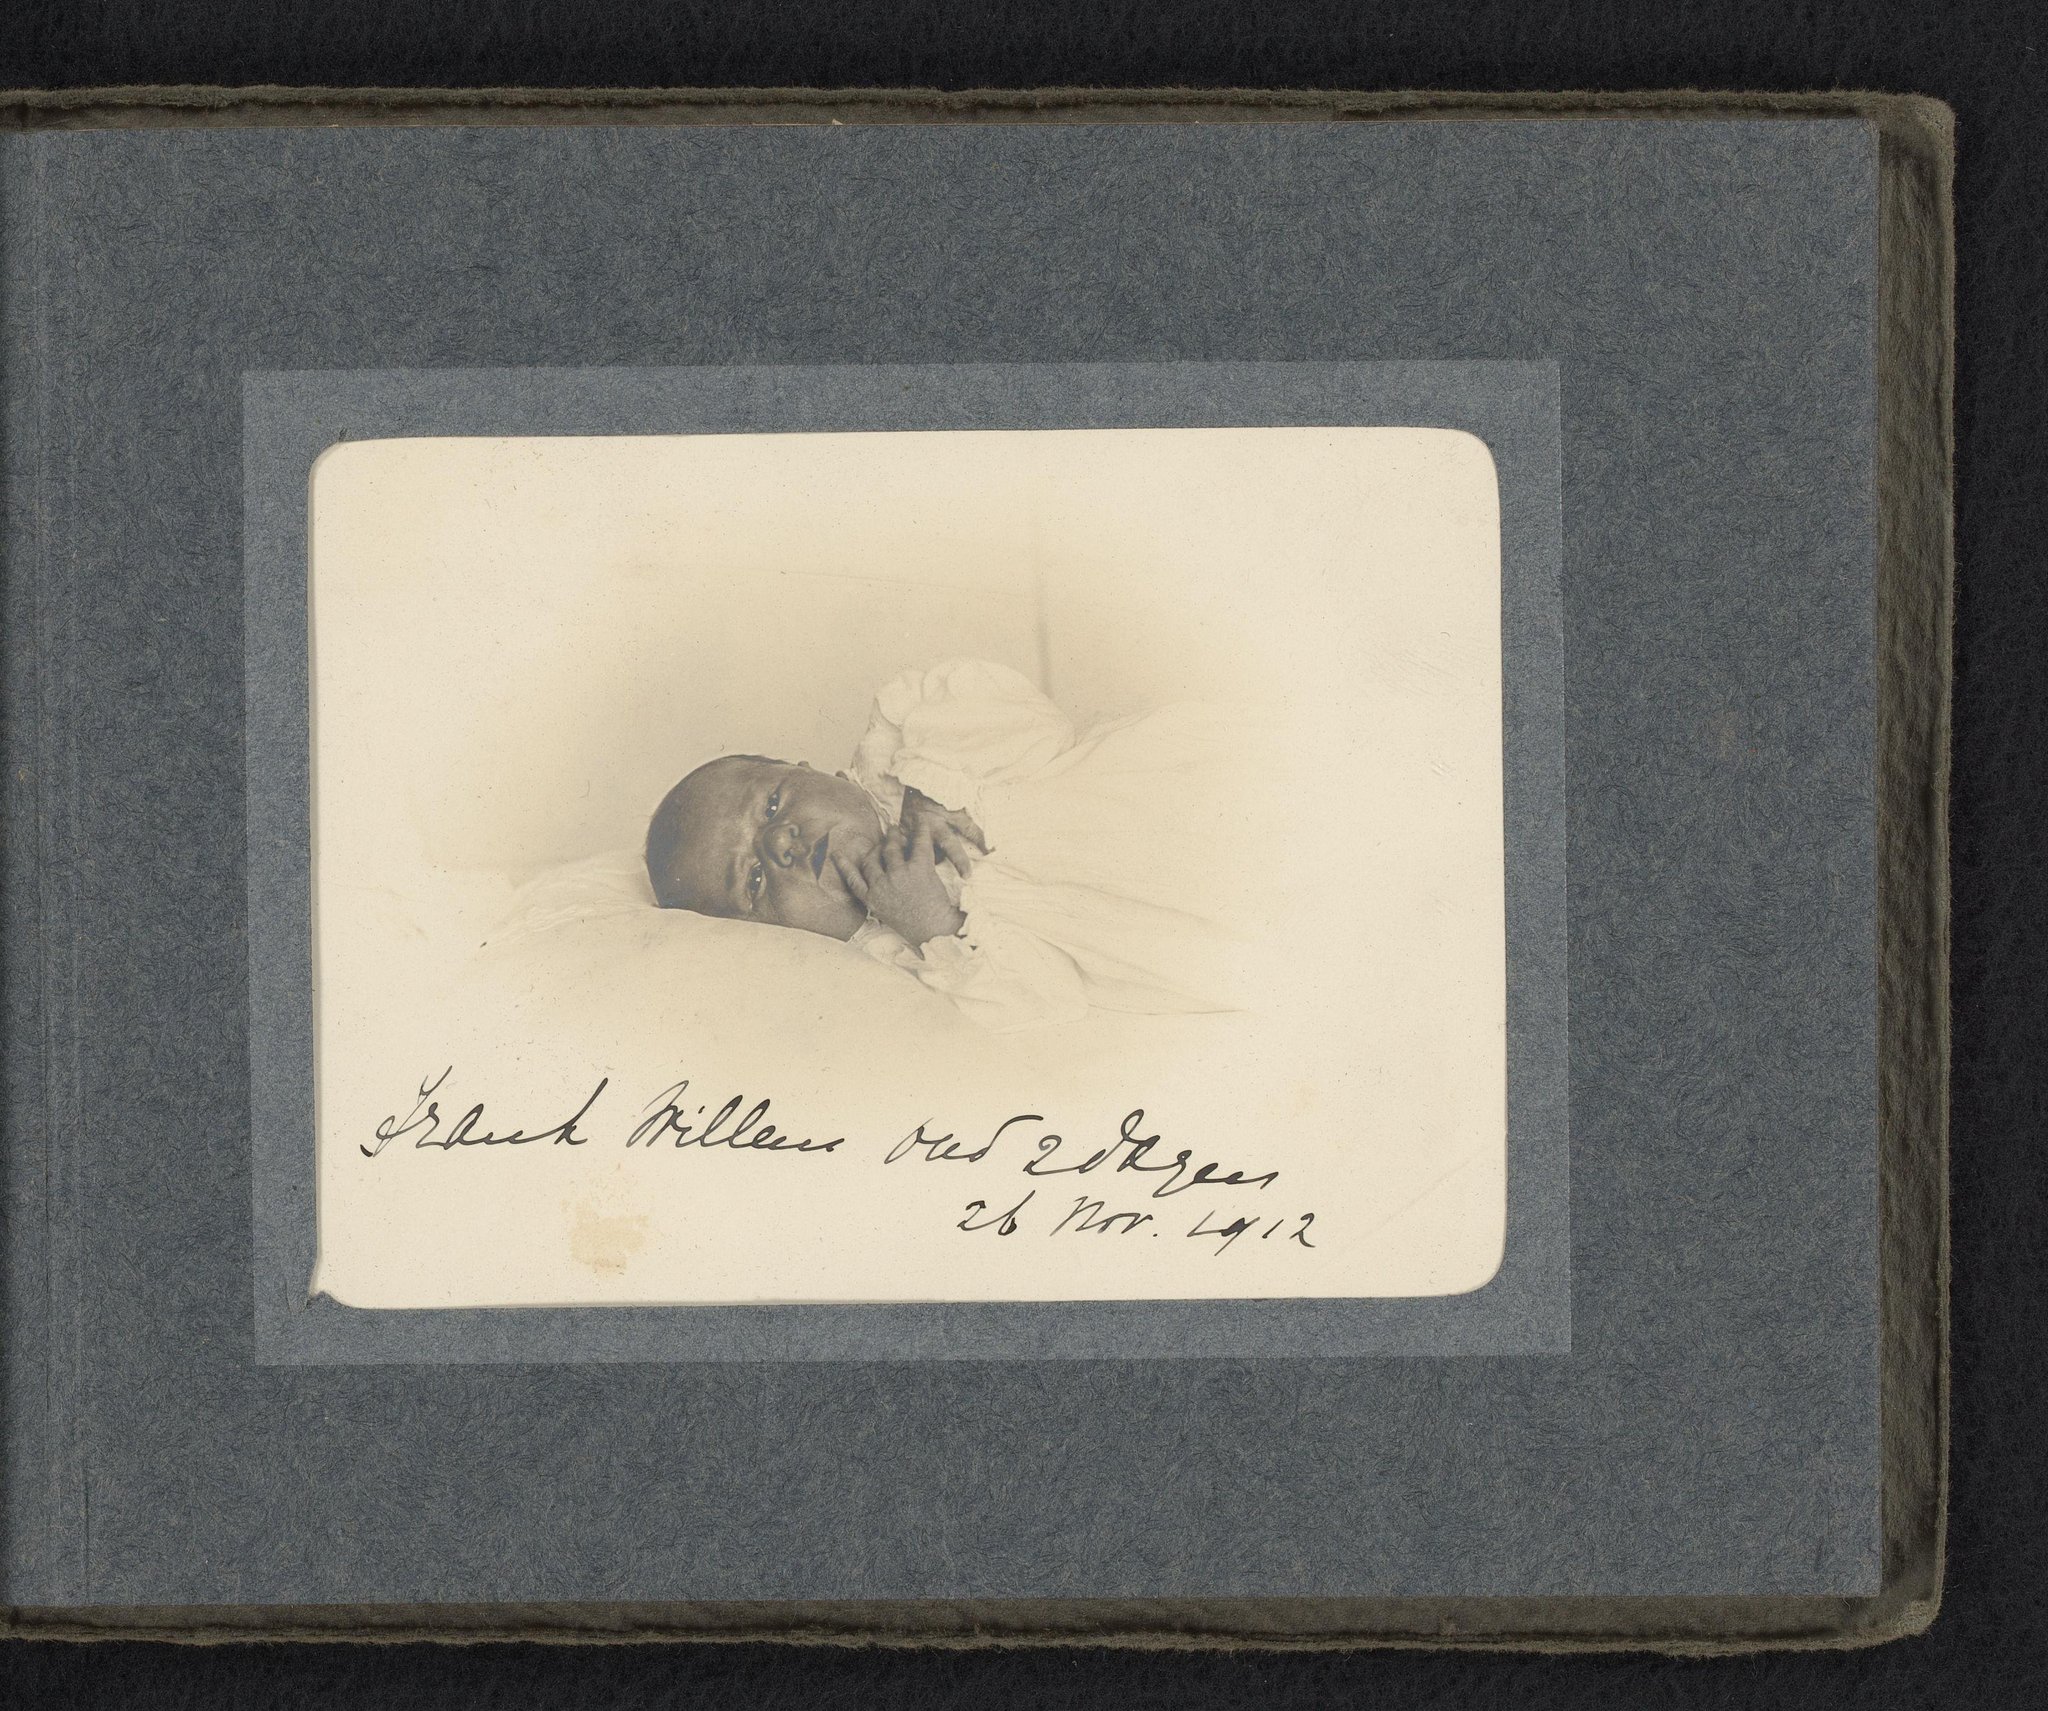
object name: album leaf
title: Frank van den Berg, twee dagen oud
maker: hendrik herman van den berg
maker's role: amateurfotograaf, jurist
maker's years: 1875-1944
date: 1912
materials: paper, cardboard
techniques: gelatin silver print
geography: amsterdam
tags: frank willem van den berg (1912-1998), historical persons, infant, baby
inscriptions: inscription: ‘Frank Willem oud 2 dagen/ 26 nov. 1912’